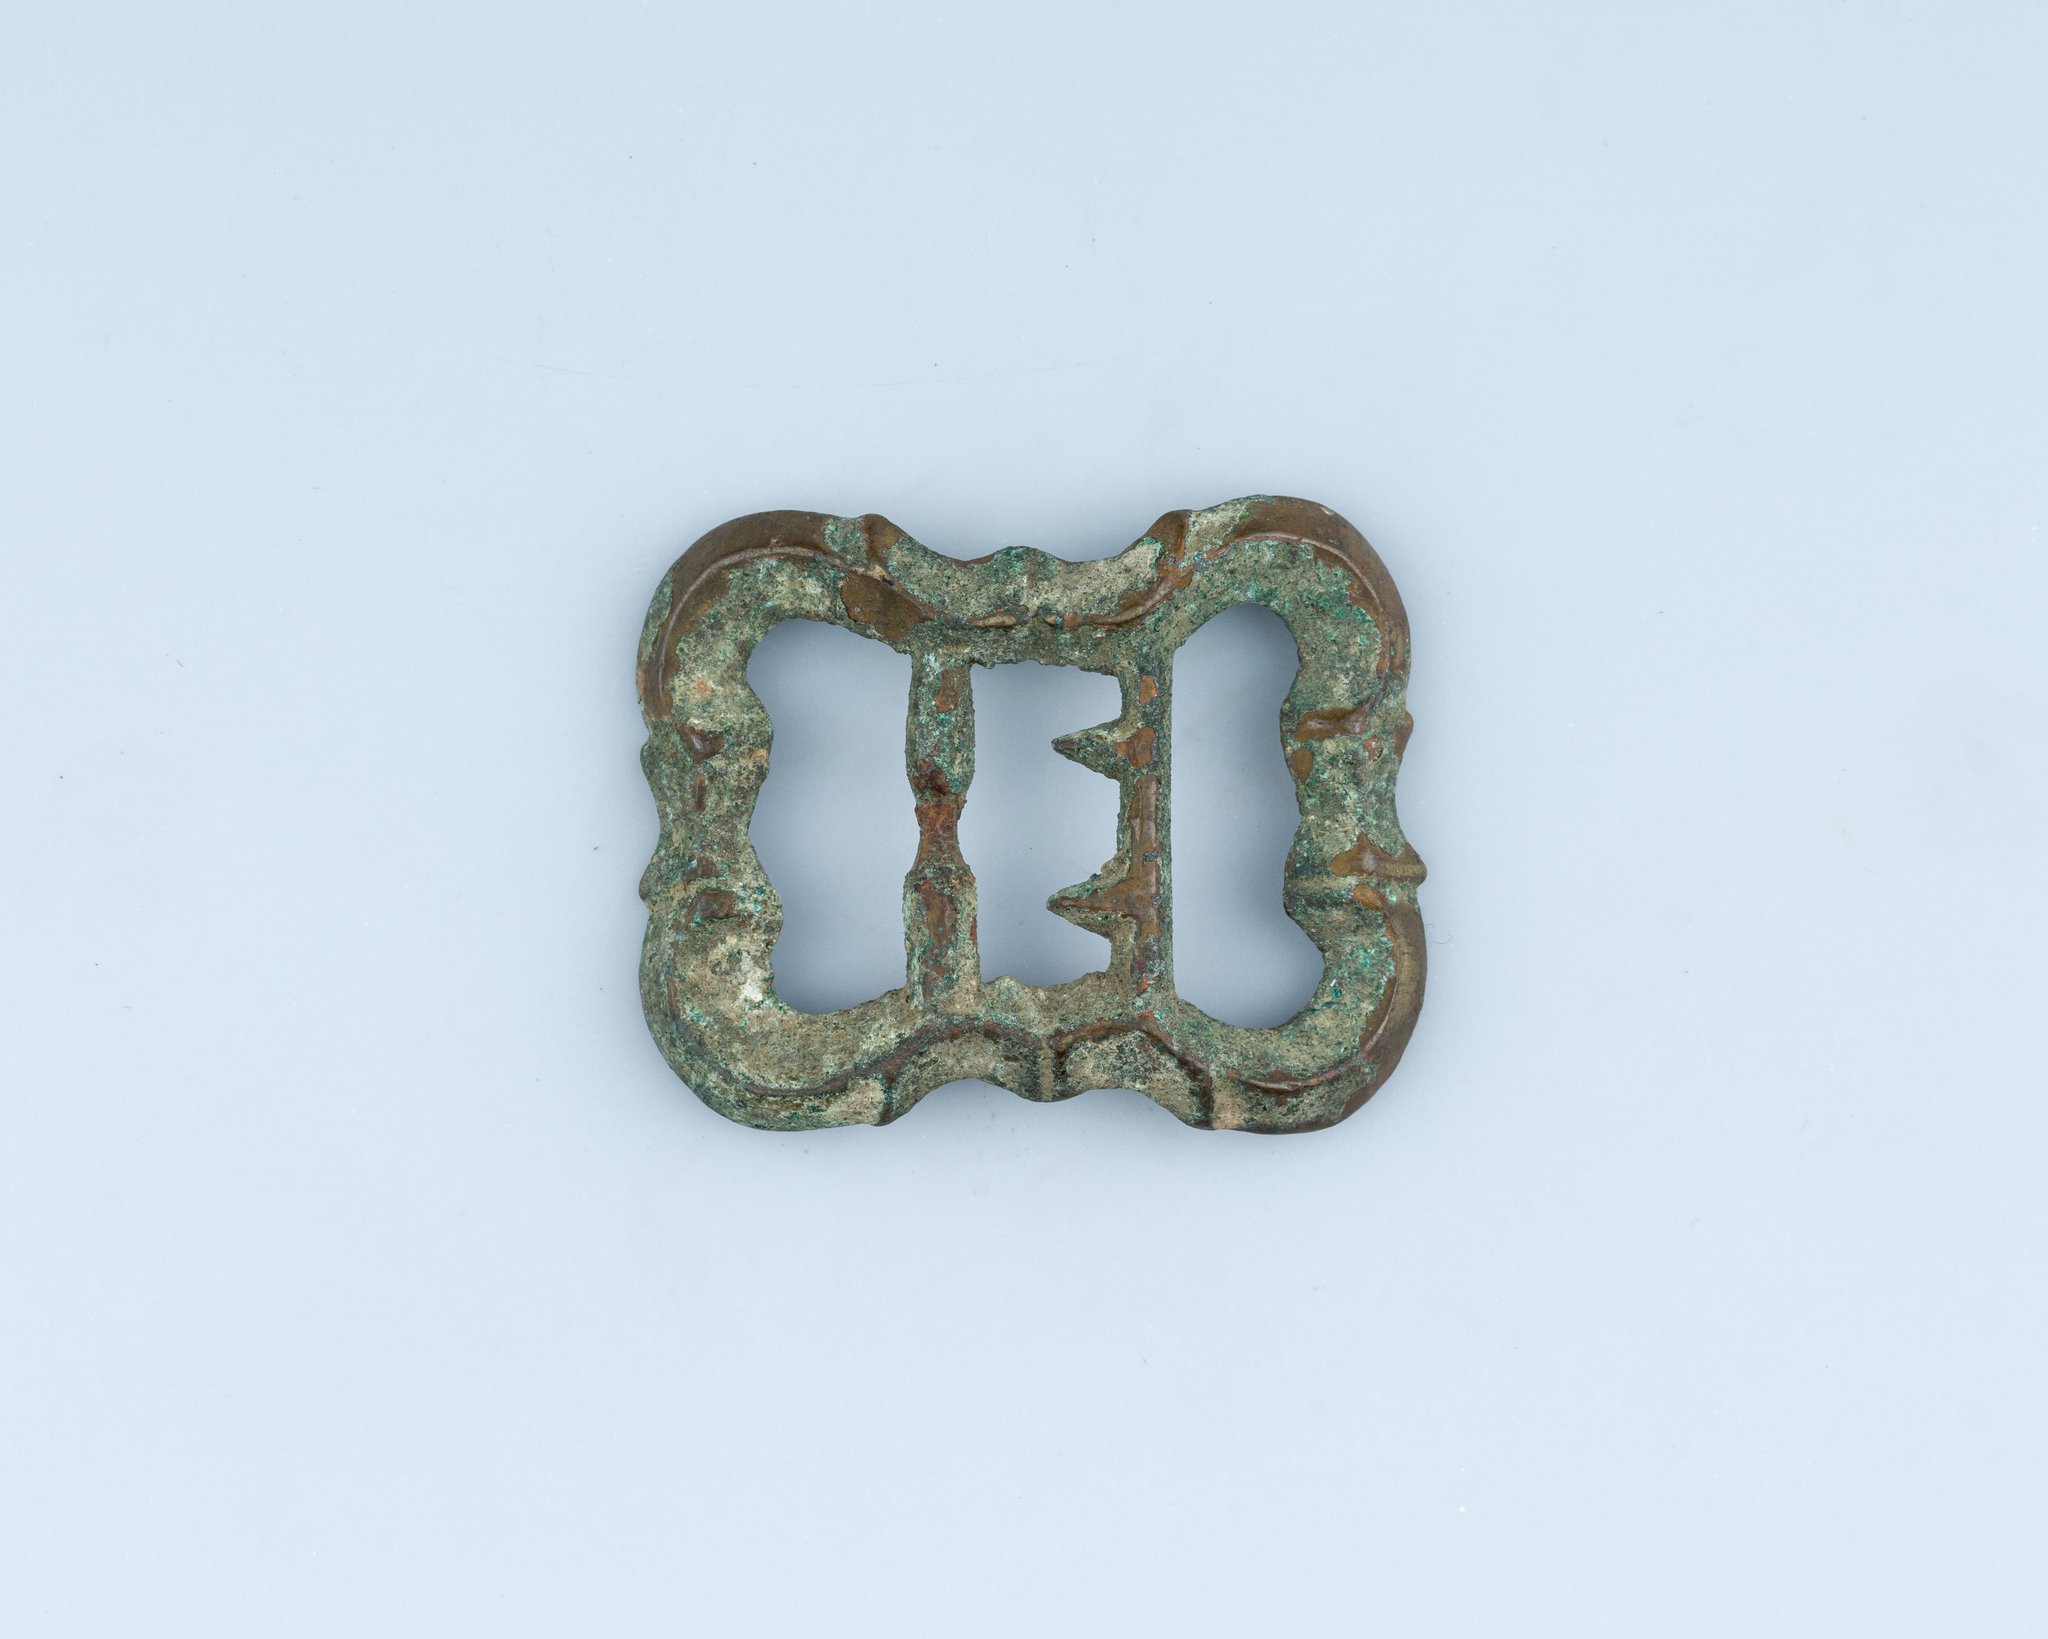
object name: buckle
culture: european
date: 1401-1700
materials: bronze